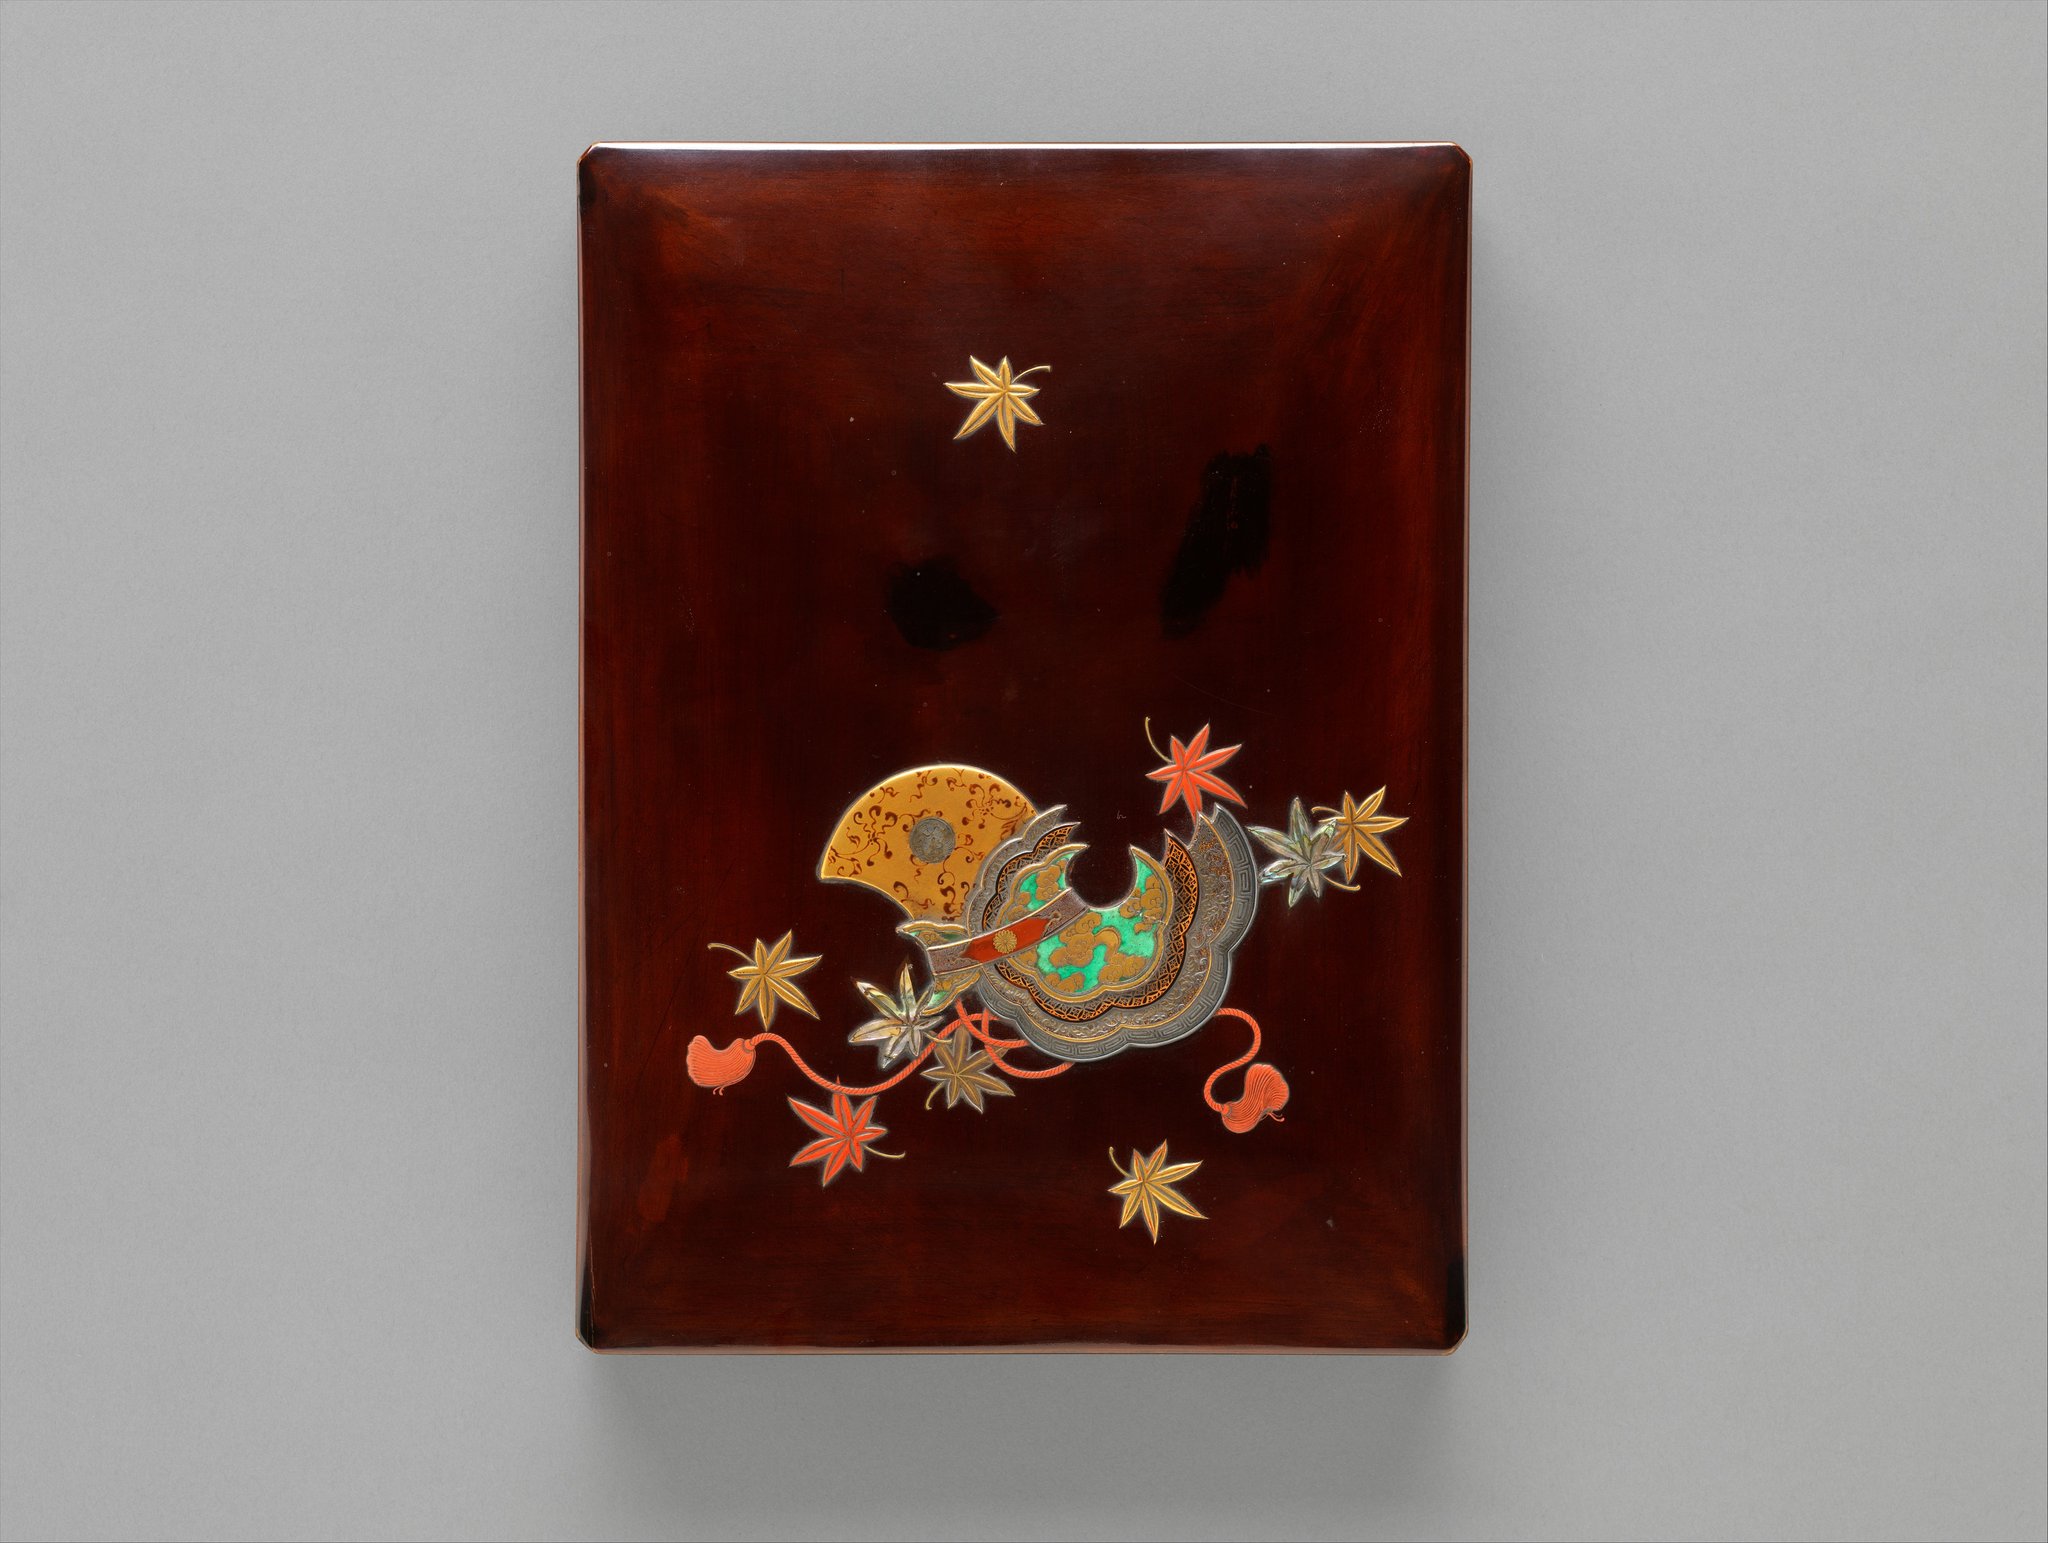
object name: writing box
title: Writing Box with Design of Maple Leaves and Bugaku Hat from the Tale of Genji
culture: japanese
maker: ogawa haritsu (ritsuō)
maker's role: artist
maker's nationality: japanese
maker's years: 1663-1747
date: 1701-1800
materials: gold, lacquer, mother of pearl, pottery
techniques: glazing, inlay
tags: hats